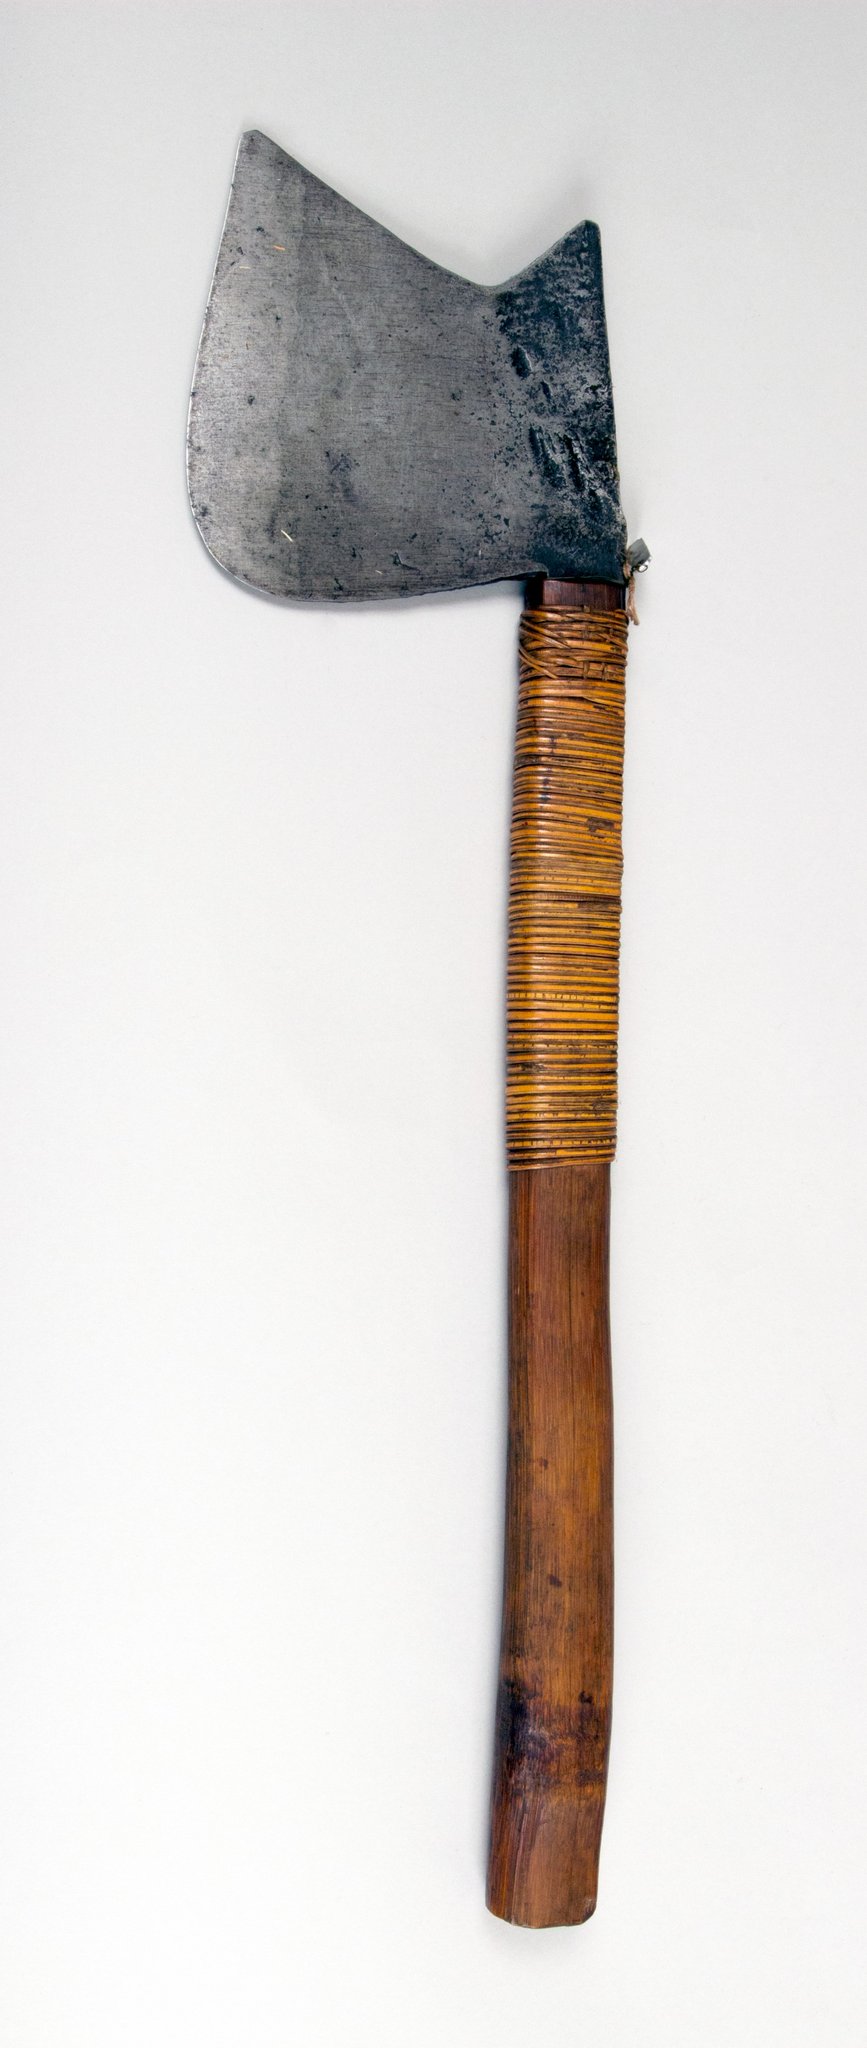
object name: axe kalyo kangyu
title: Axe ((Kalyo Kangyu)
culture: indian, assam, naga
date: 1801-1900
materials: iron, rattan, wood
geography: india